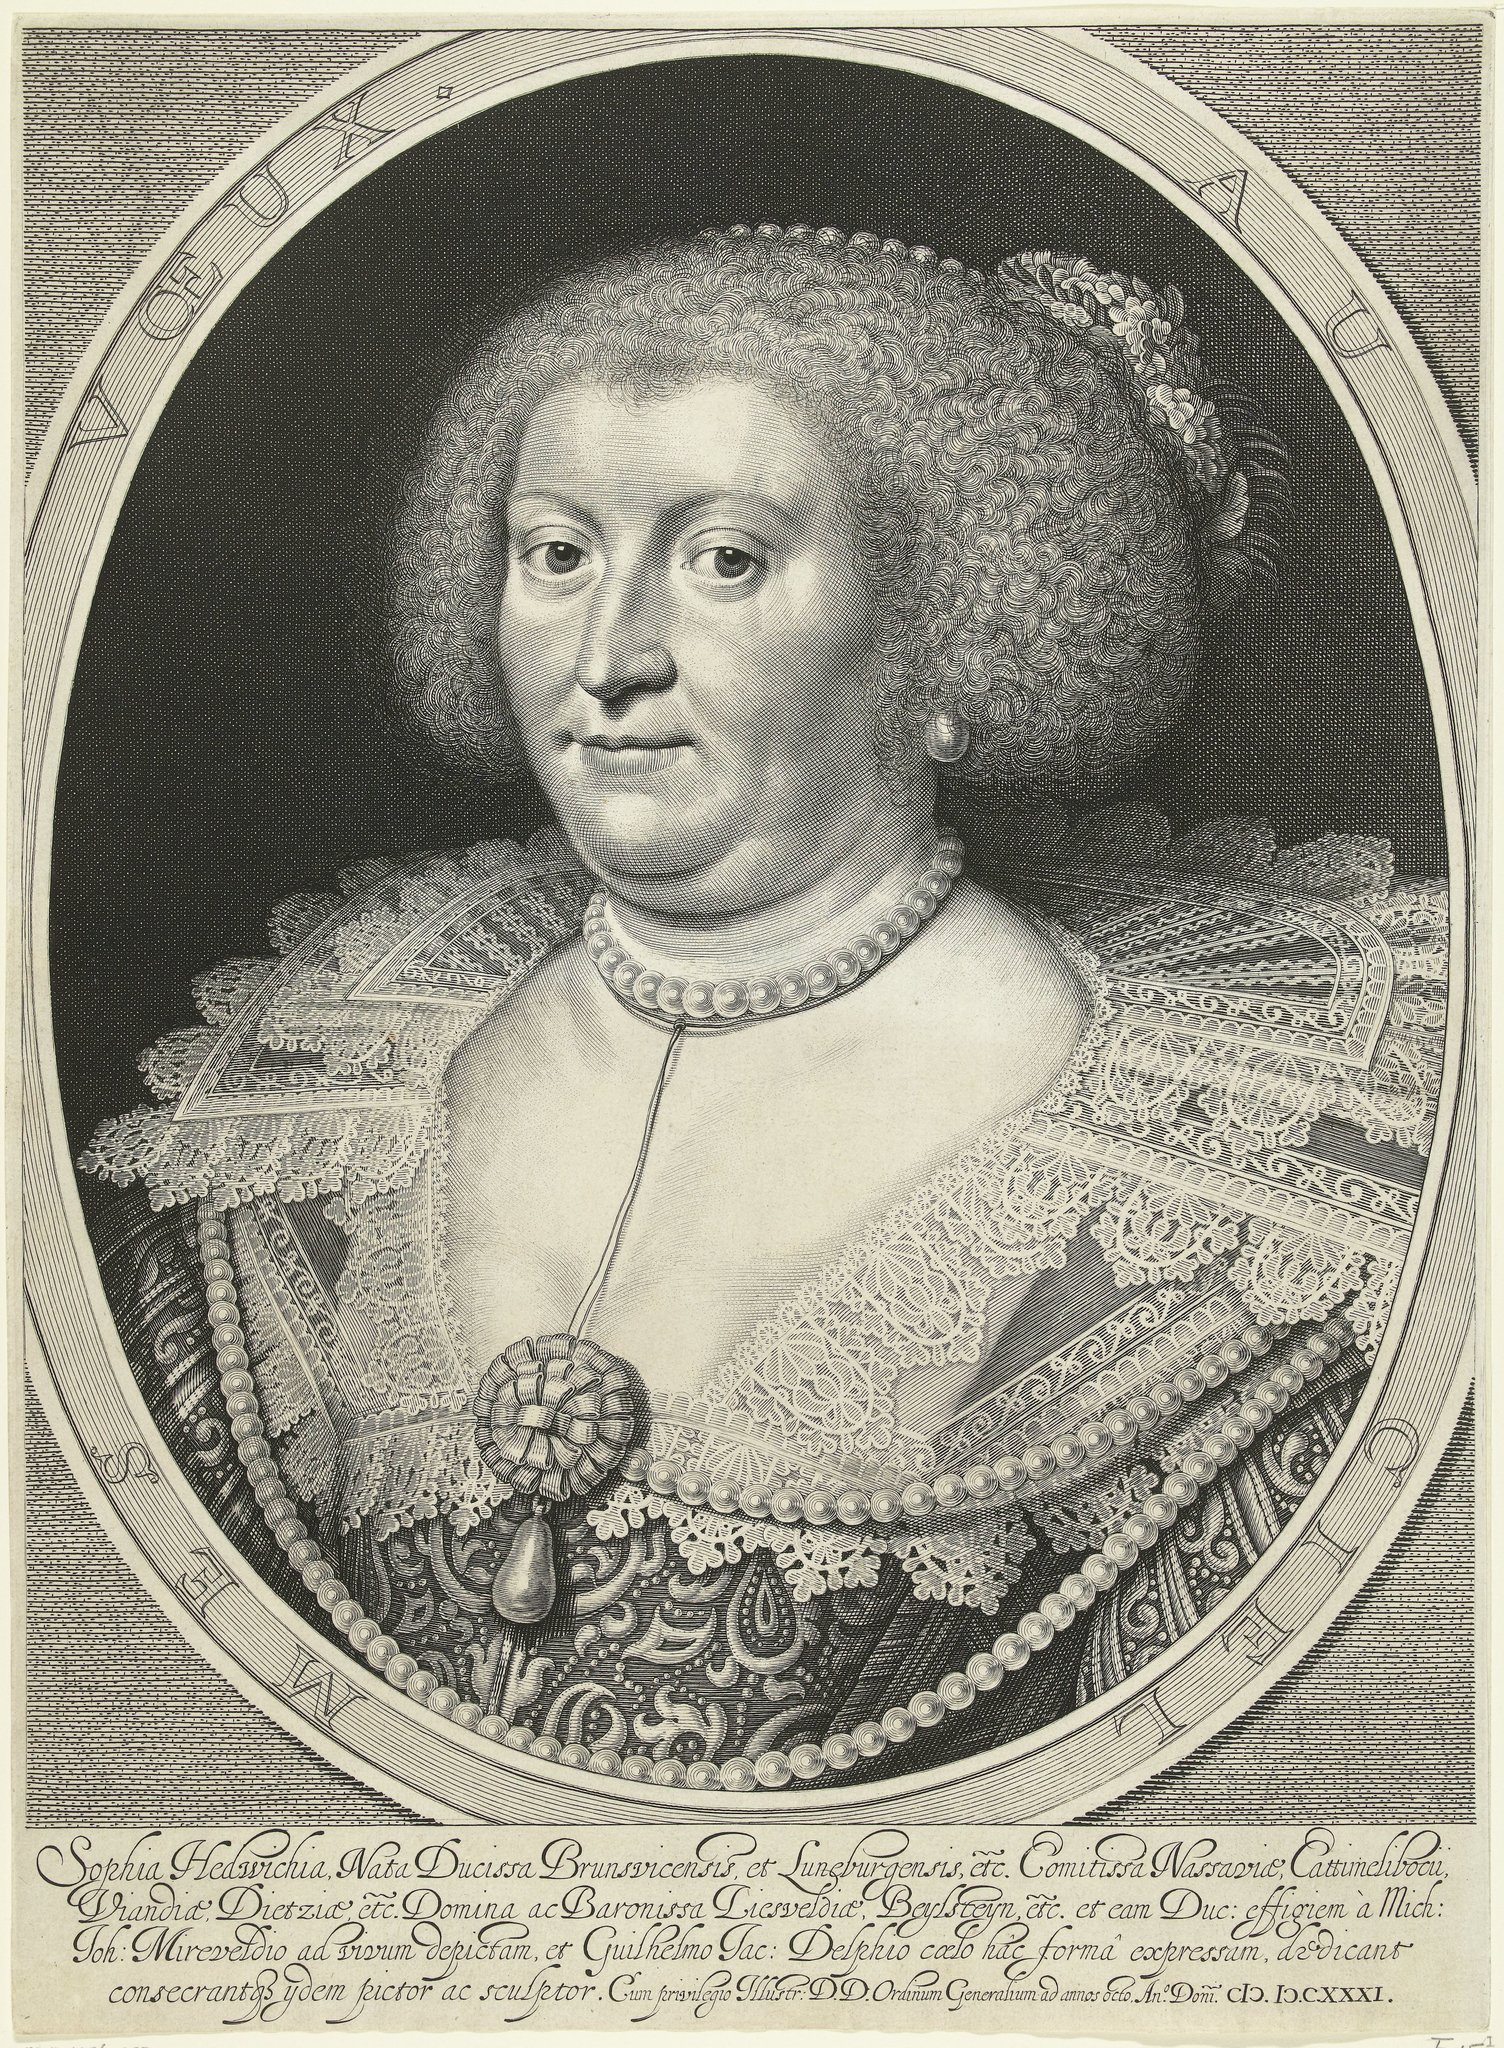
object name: print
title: Portret van Sophia Hedwig van Brunswijk-Wolfenbüttel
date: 1631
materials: paper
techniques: engraving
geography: delft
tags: sophia hedwig van brunswijk-wolfenbüttel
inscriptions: collector's mark: Lugt 2760, collector's mark: Lugt 2228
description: Portret van Sophia Hedwig van Brunswijk-Wolfenbüttel, borststuk met kanten kraag en parelsnoeren. In ovale omlijsting met motto, Latijns opschrift in vier regels in ondermarge.